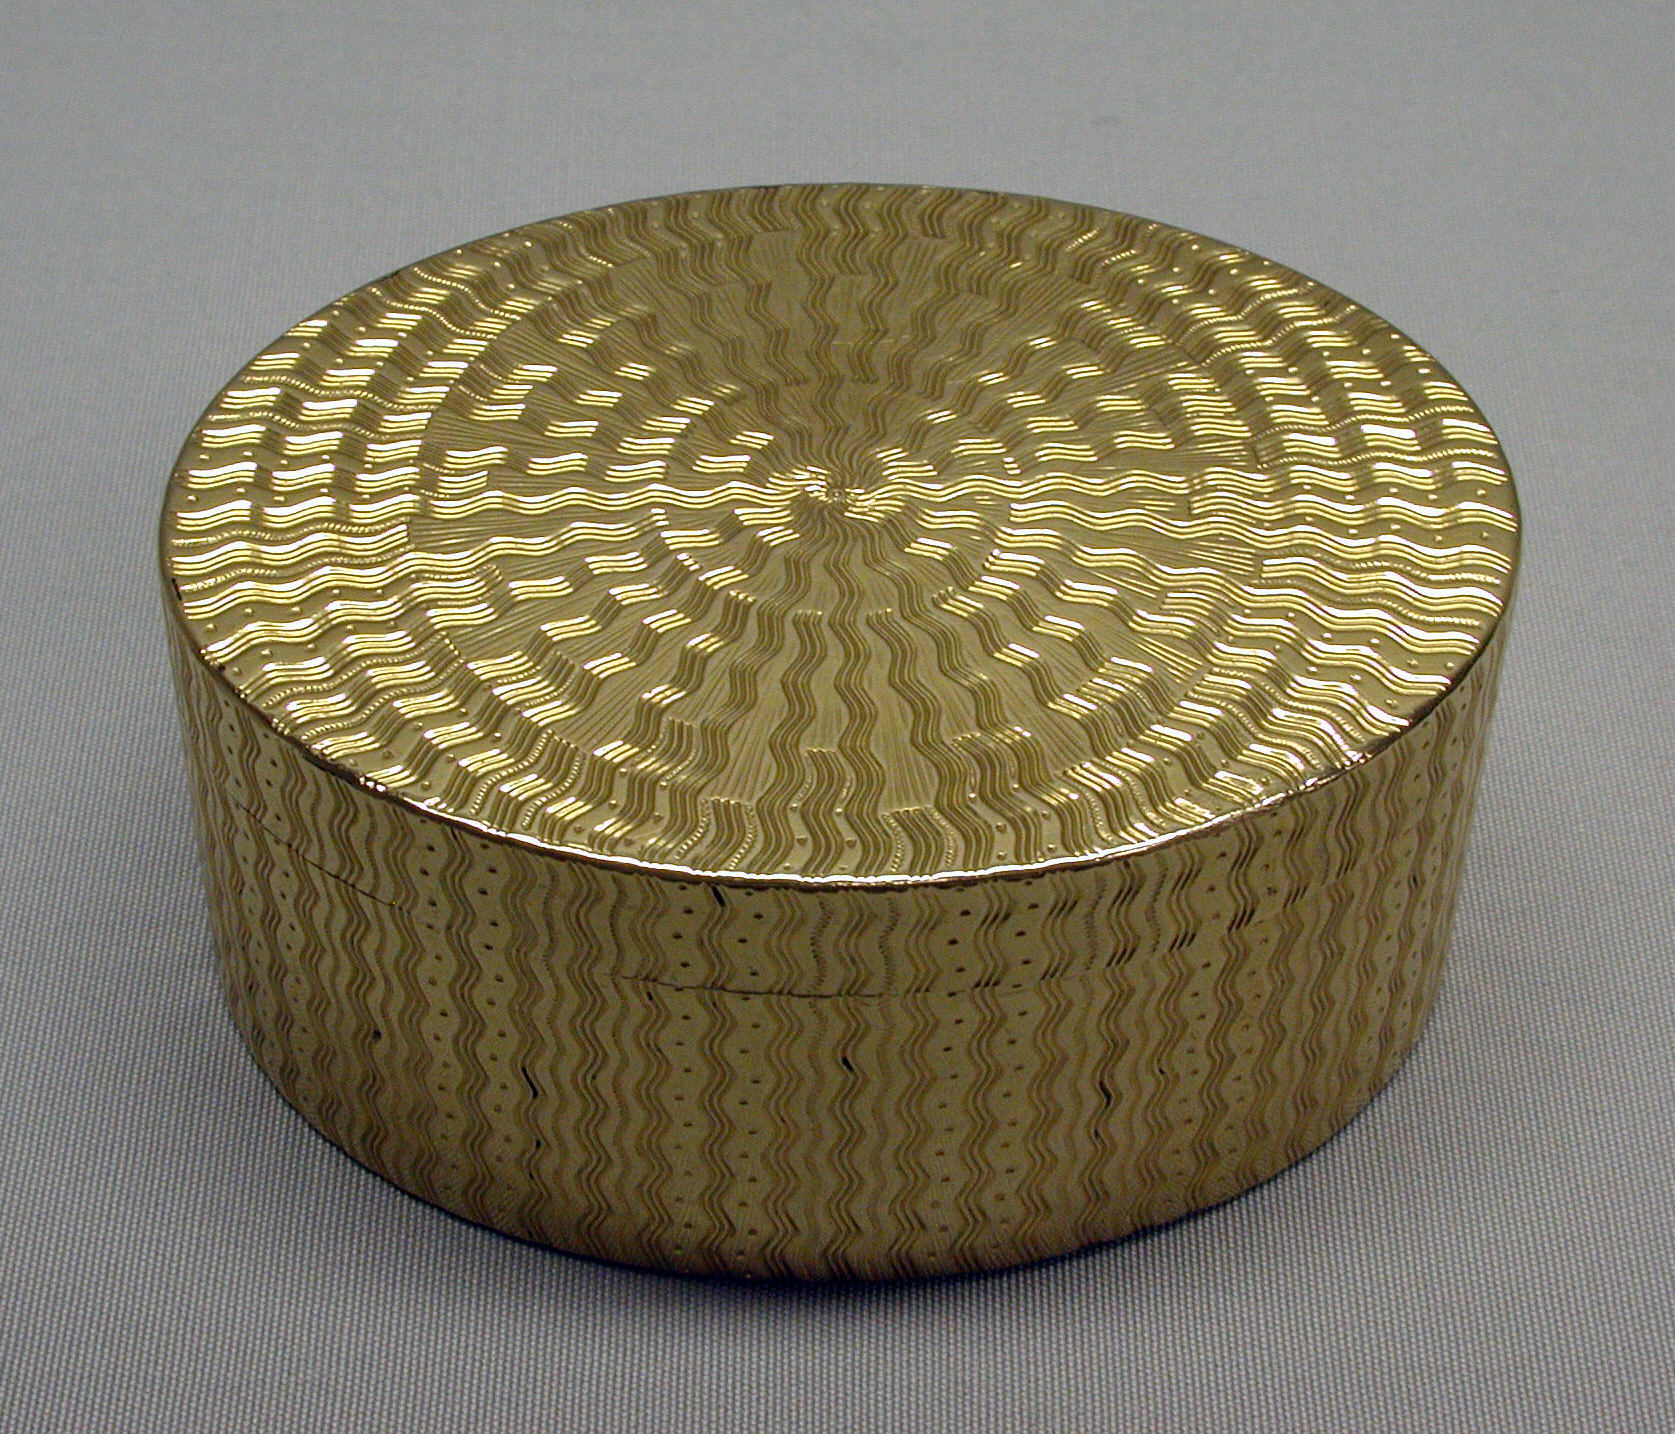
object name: snuffbox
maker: louis michelin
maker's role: maker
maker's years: 1706-1811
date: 1752-1753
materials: gold